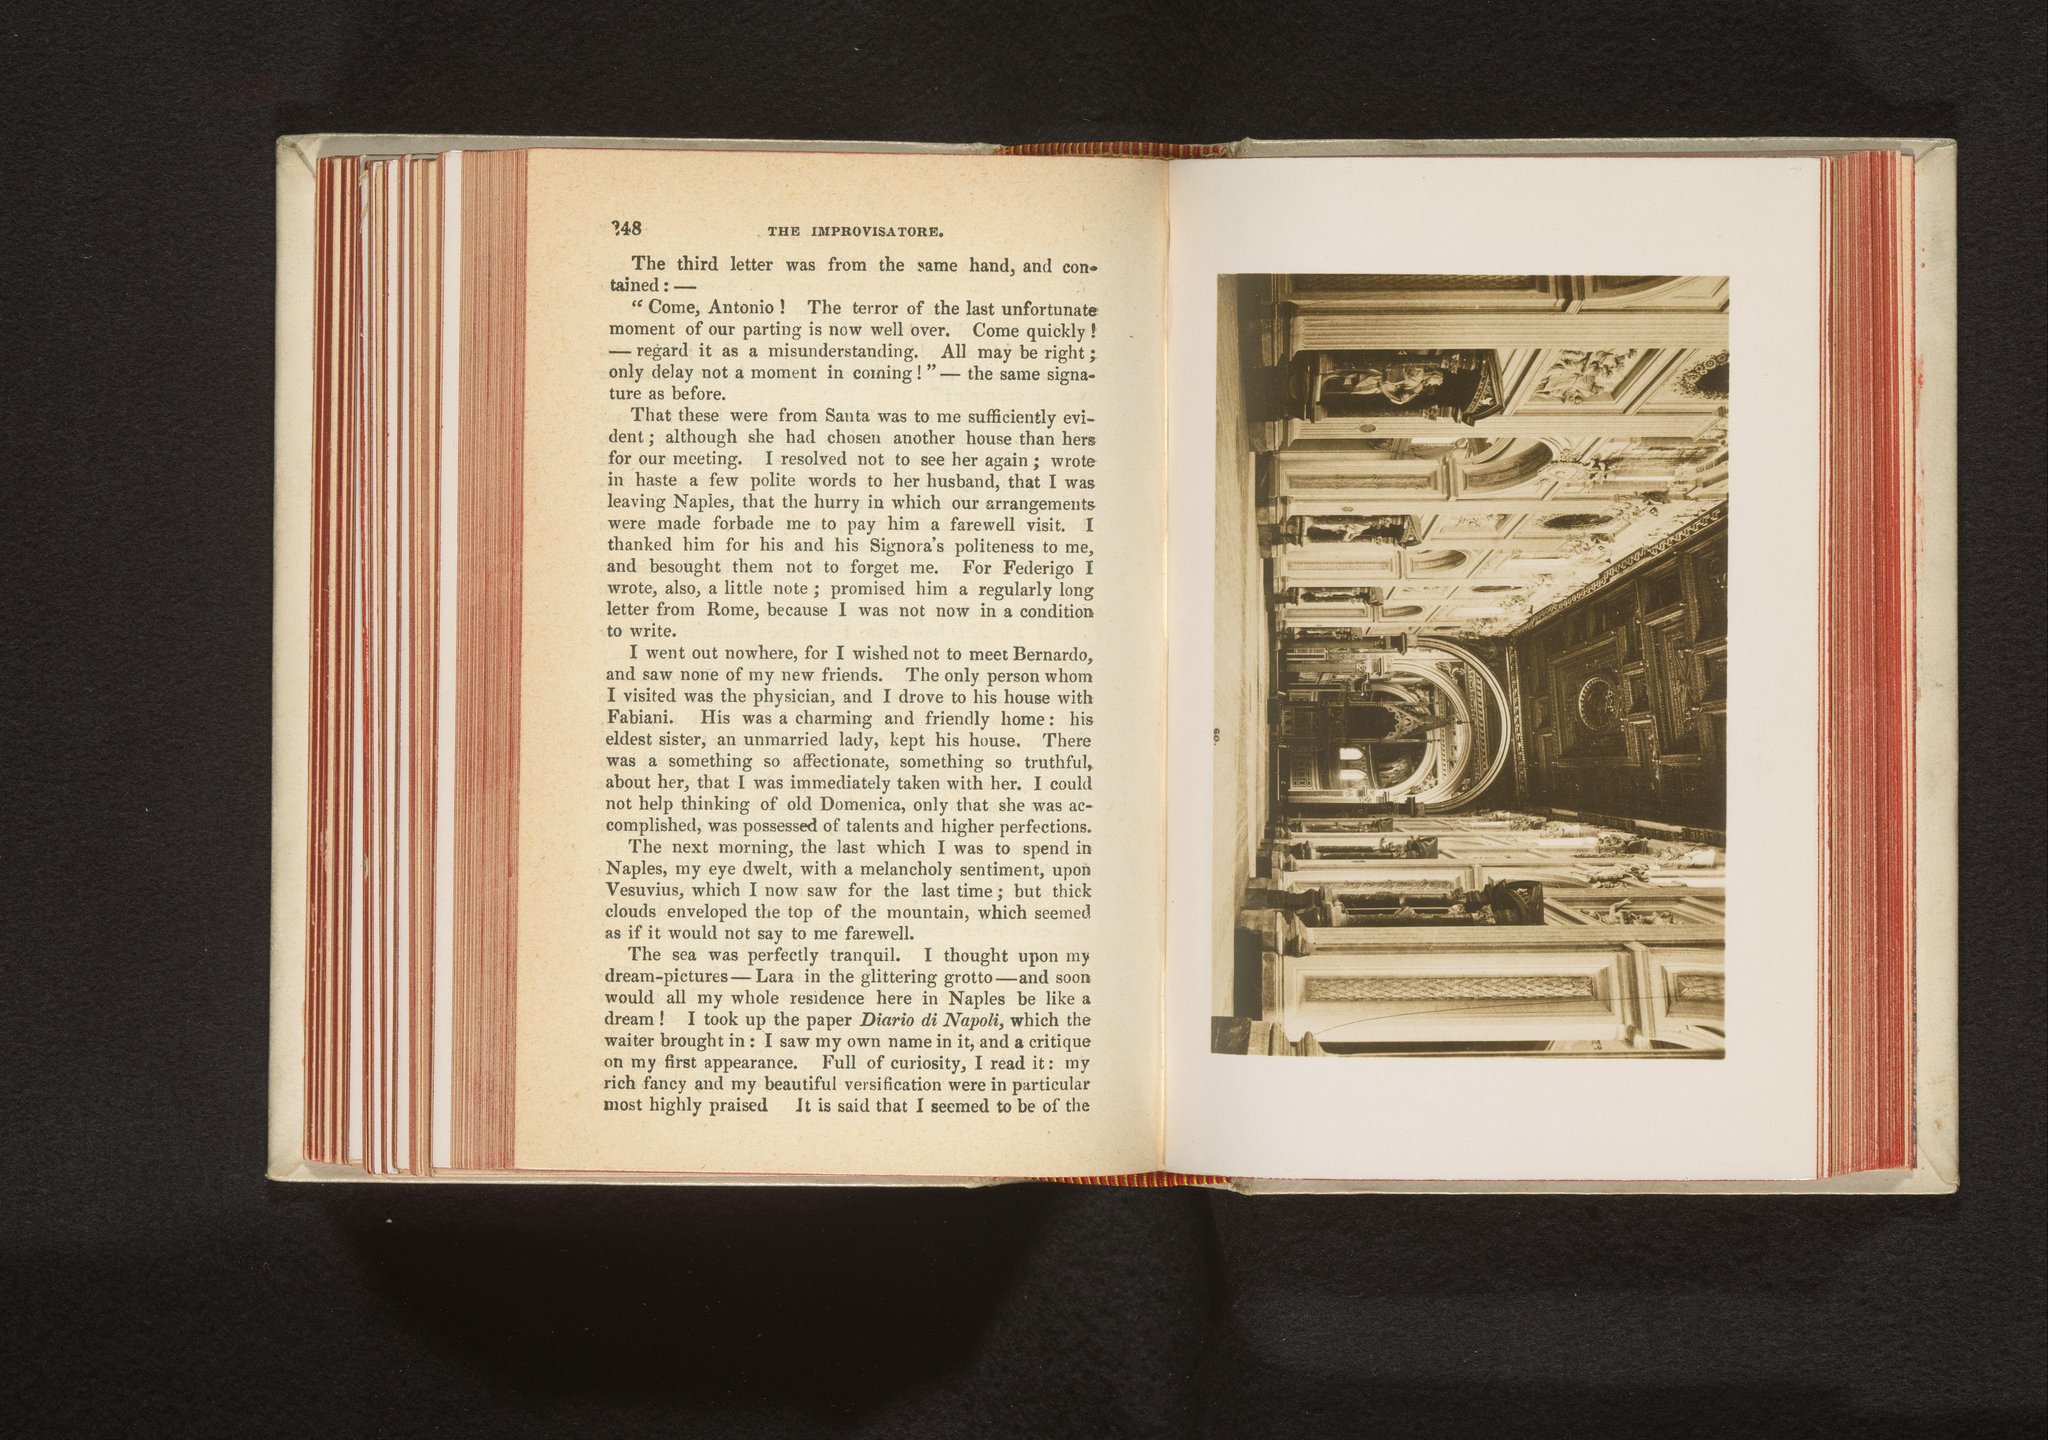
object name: page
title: Interieur van de Sint-Jan van Lateranen te Rome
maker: Anonymous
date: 1870-1880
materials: photographic support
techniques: gelatin silver print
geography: sint-jan van lateranen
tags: interior of church